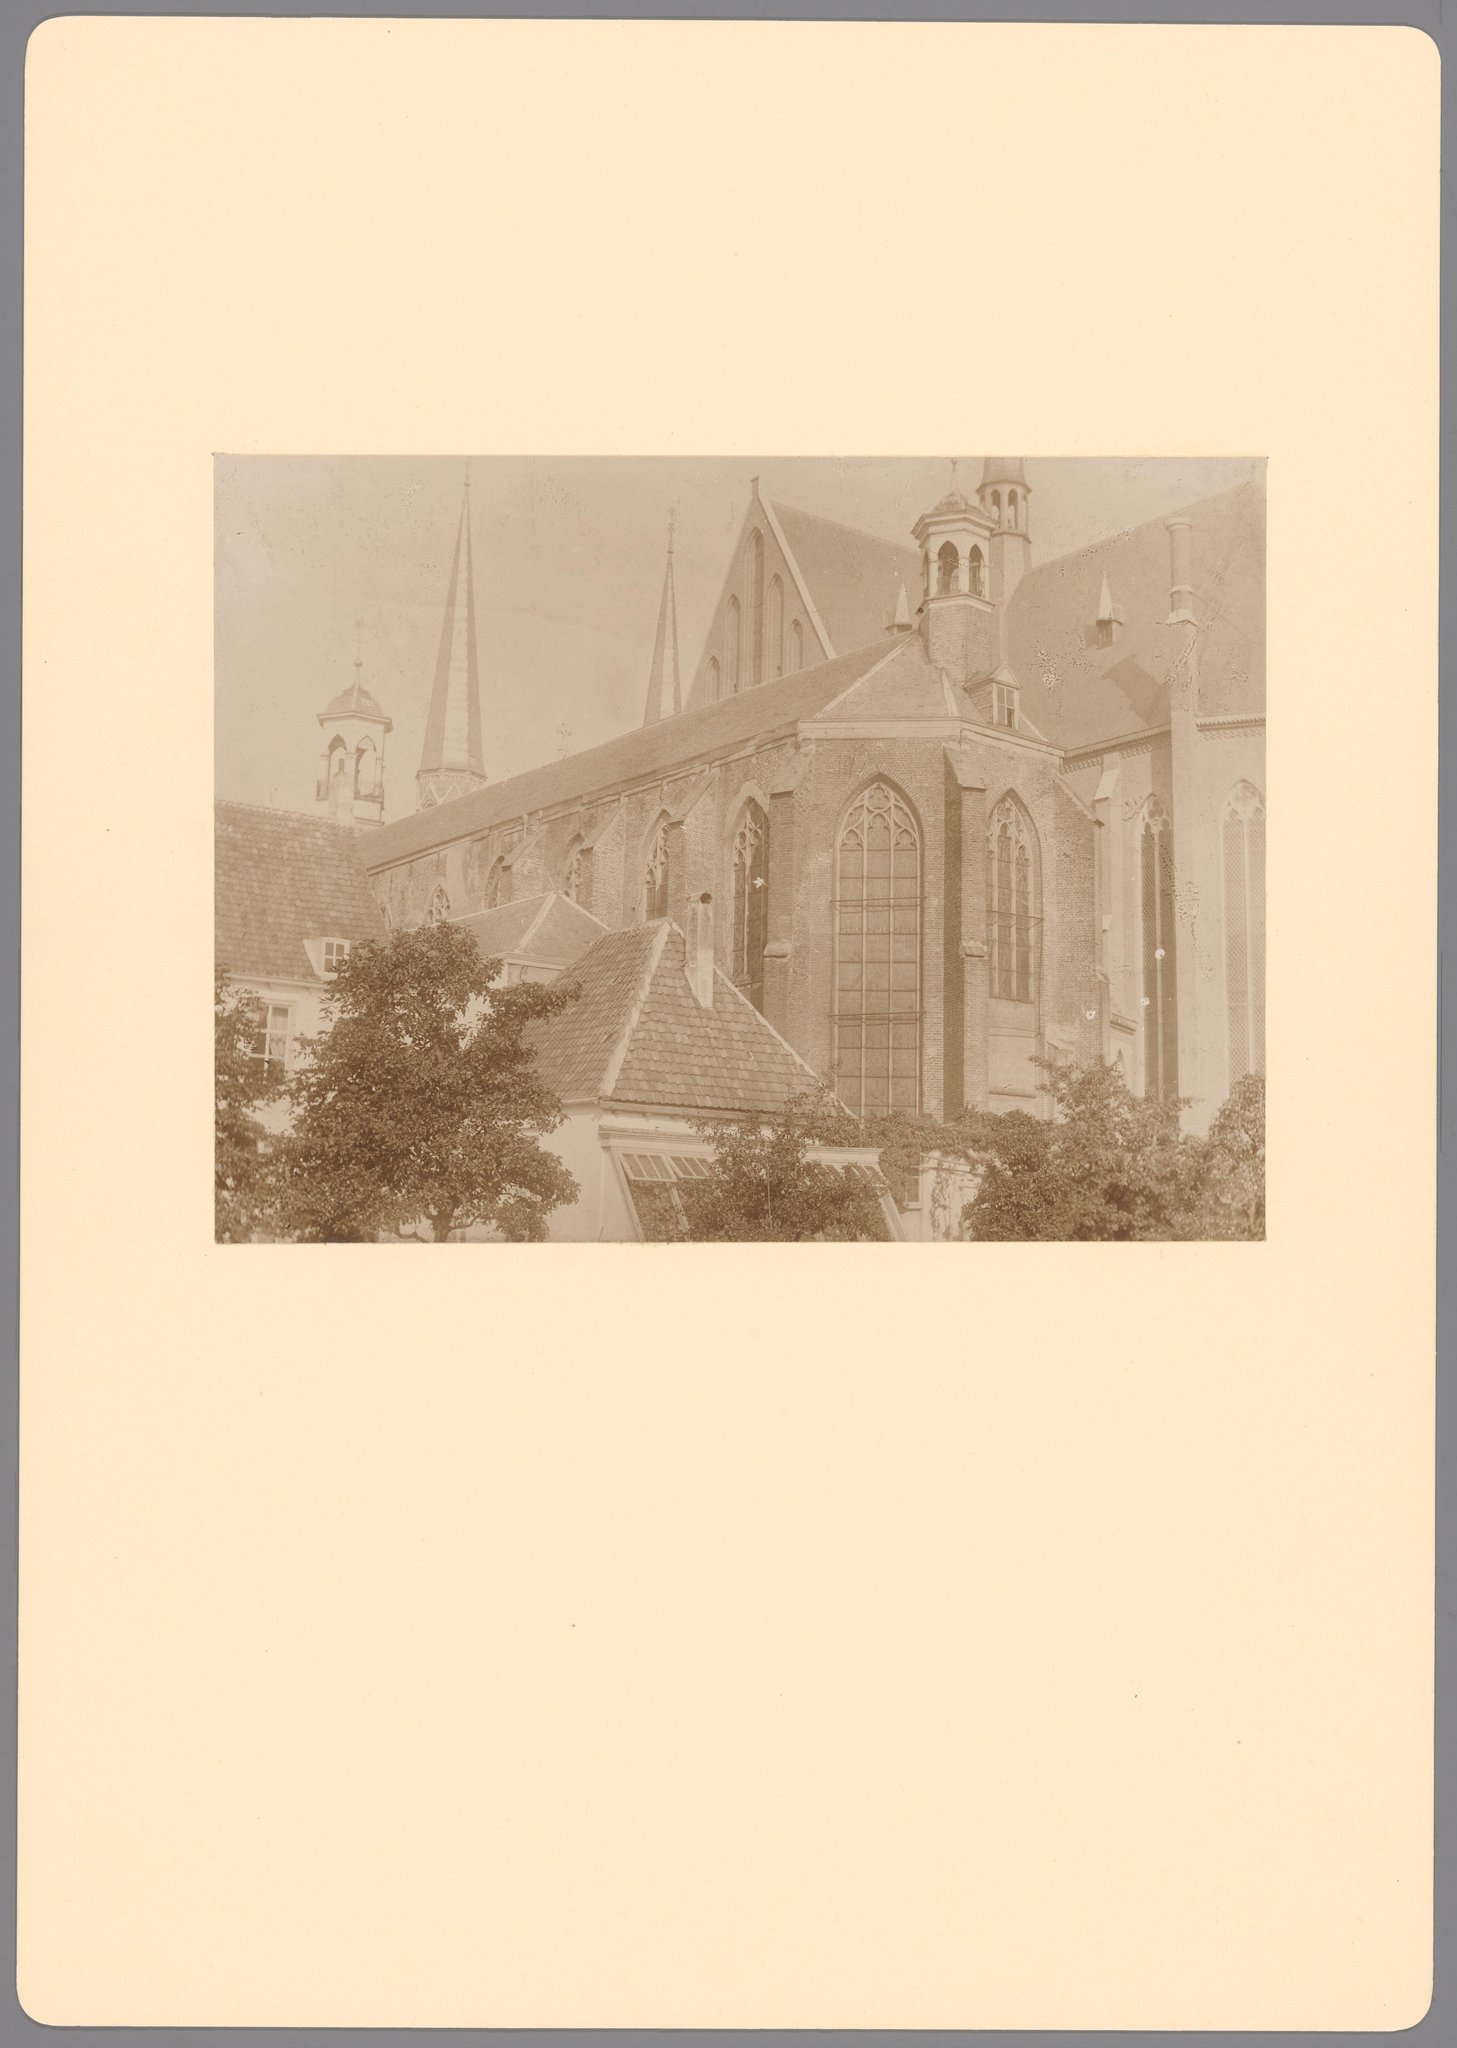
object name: photograph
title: Gezicht op de oude Sint-Ignatiuskerk te Nijmegen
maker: anoniem (monumentenzorg)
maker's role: fotograaf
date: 1890-1920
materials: cardboard, photographic support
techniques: collodion silver print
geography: nijmegen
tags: church (exterior), nijmegen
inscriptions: annotation: ‘De oude Ignatius kerk in de Molenstr gezien van de zuid-oost zijde’